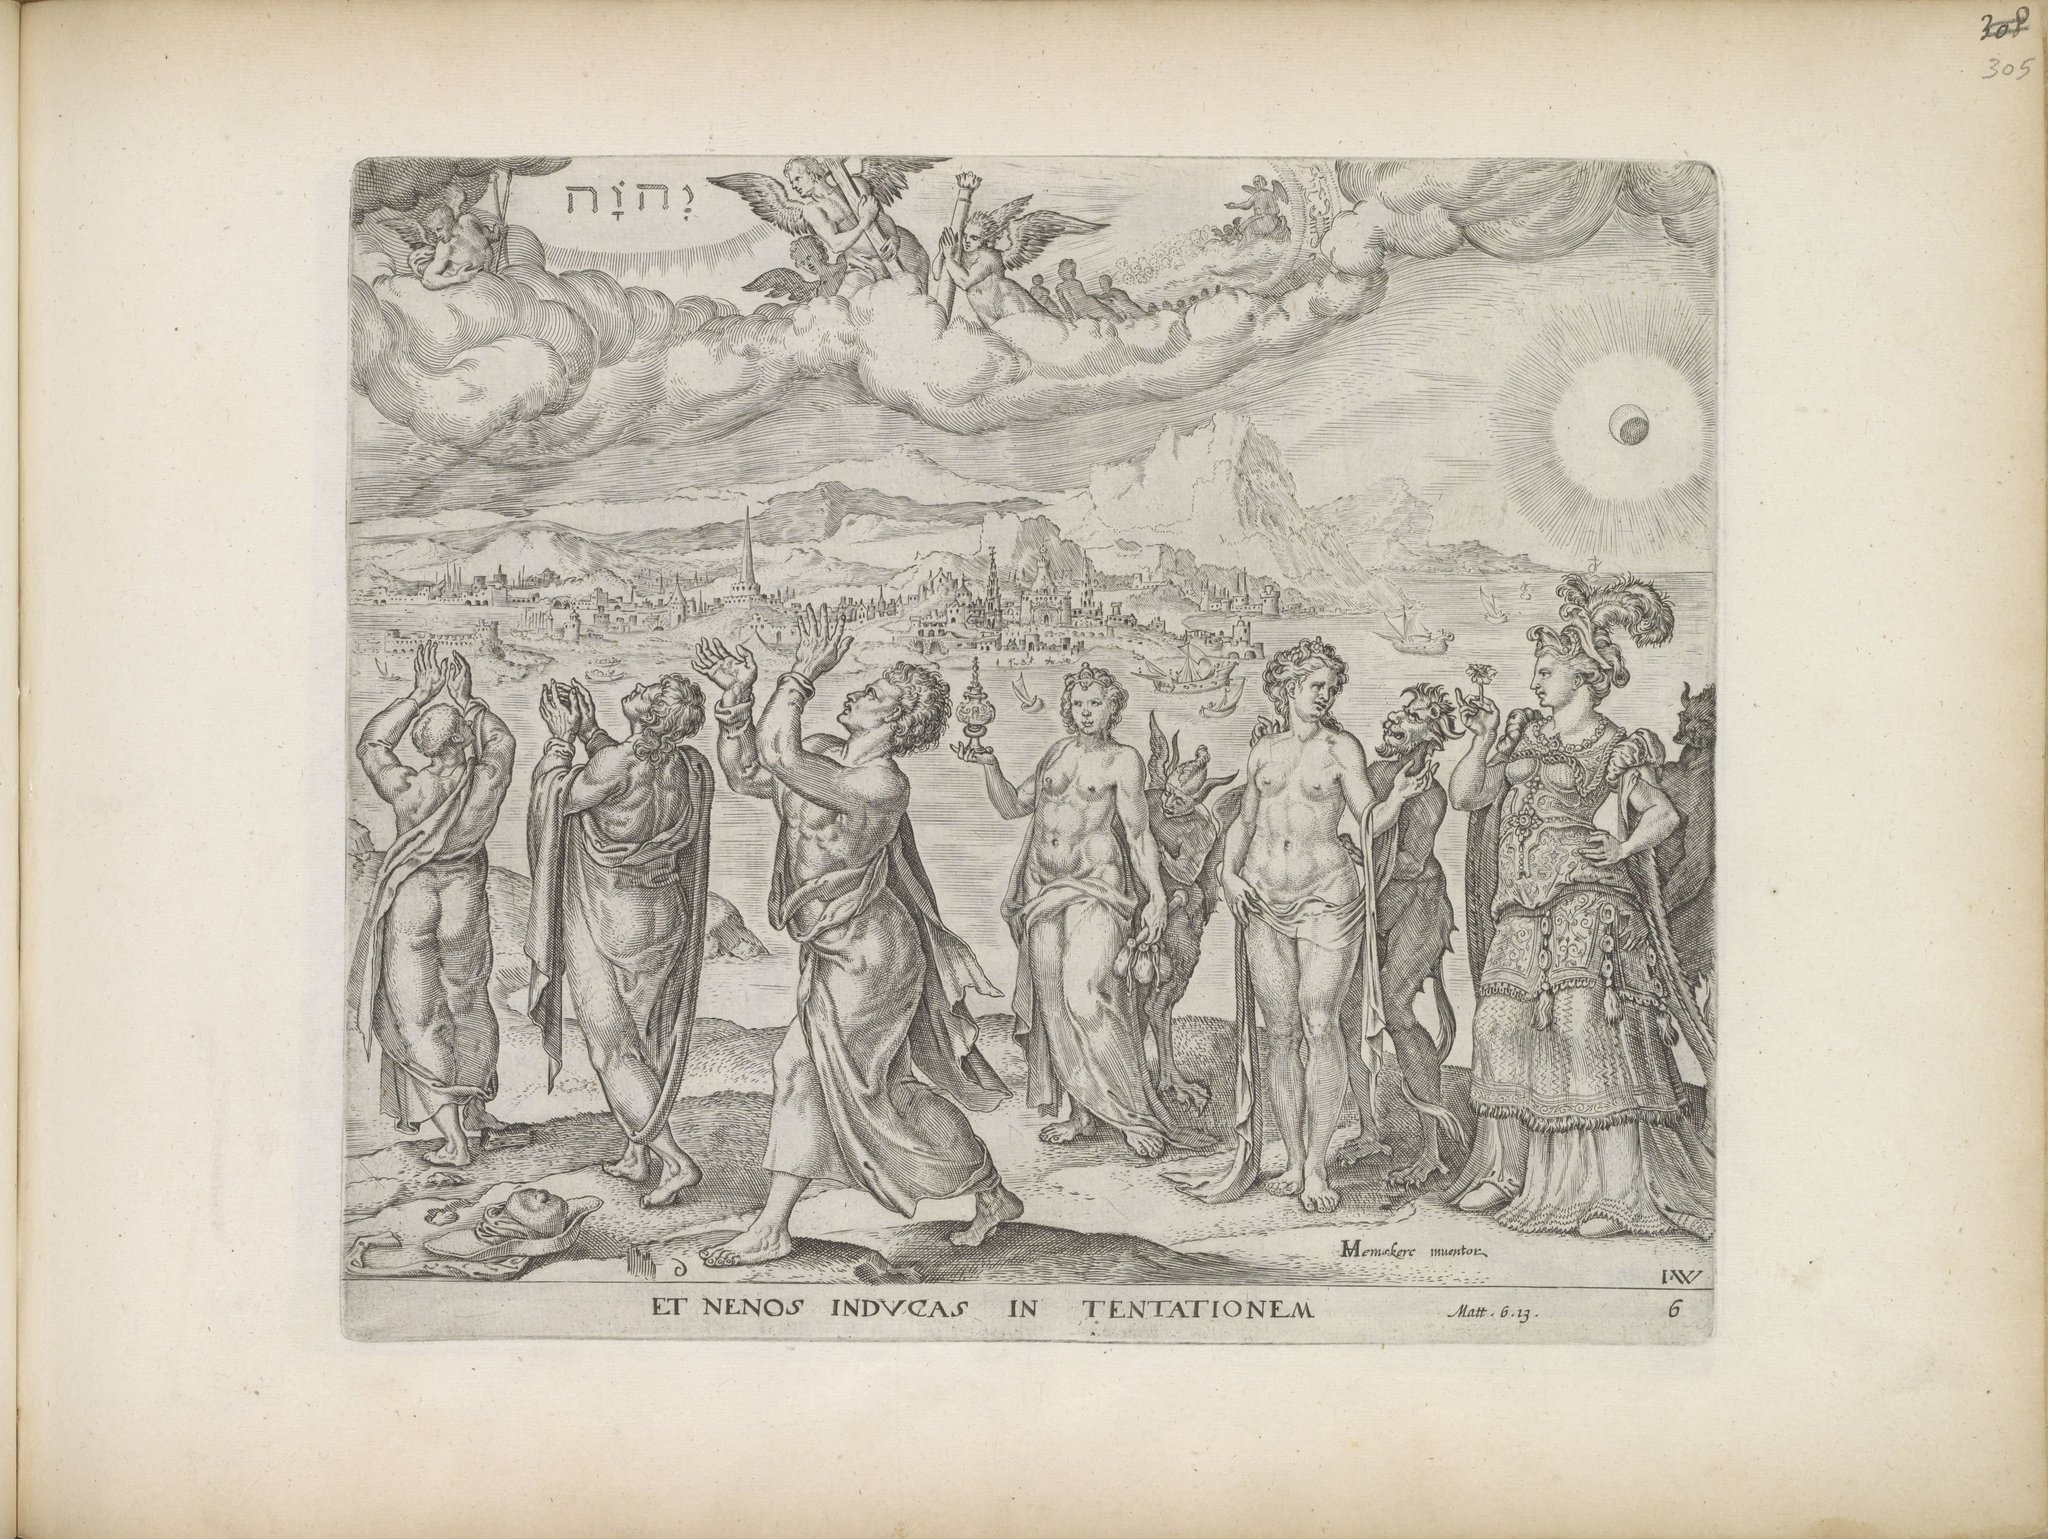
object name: print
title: Onze Vader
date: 1569-1573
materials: paper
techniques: engraving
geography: amsterdam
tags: tetragram (in roman or hebrew script) ~ symbol of god the father, 'and lead us not into temptation' ~ the lord's prayer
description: Illustratie van een regel van het Onze Vader gebed: Breng ons niet in beproeving. Mannen bidden tot de hemel, waar het tetragram als symbool van God de Vader verschijnt. Rechts staan drie personificaties van beproevingen: Geld, Lust en Eerzucht. Achter hen gaan duivels schuil. Onder de voorstelling dit gedeelte van het Onze Vader in het Latijn en een verwijzing naar de Bijbeltekst in Mat. 6:13. Deze prent maakt deel uit van een album.